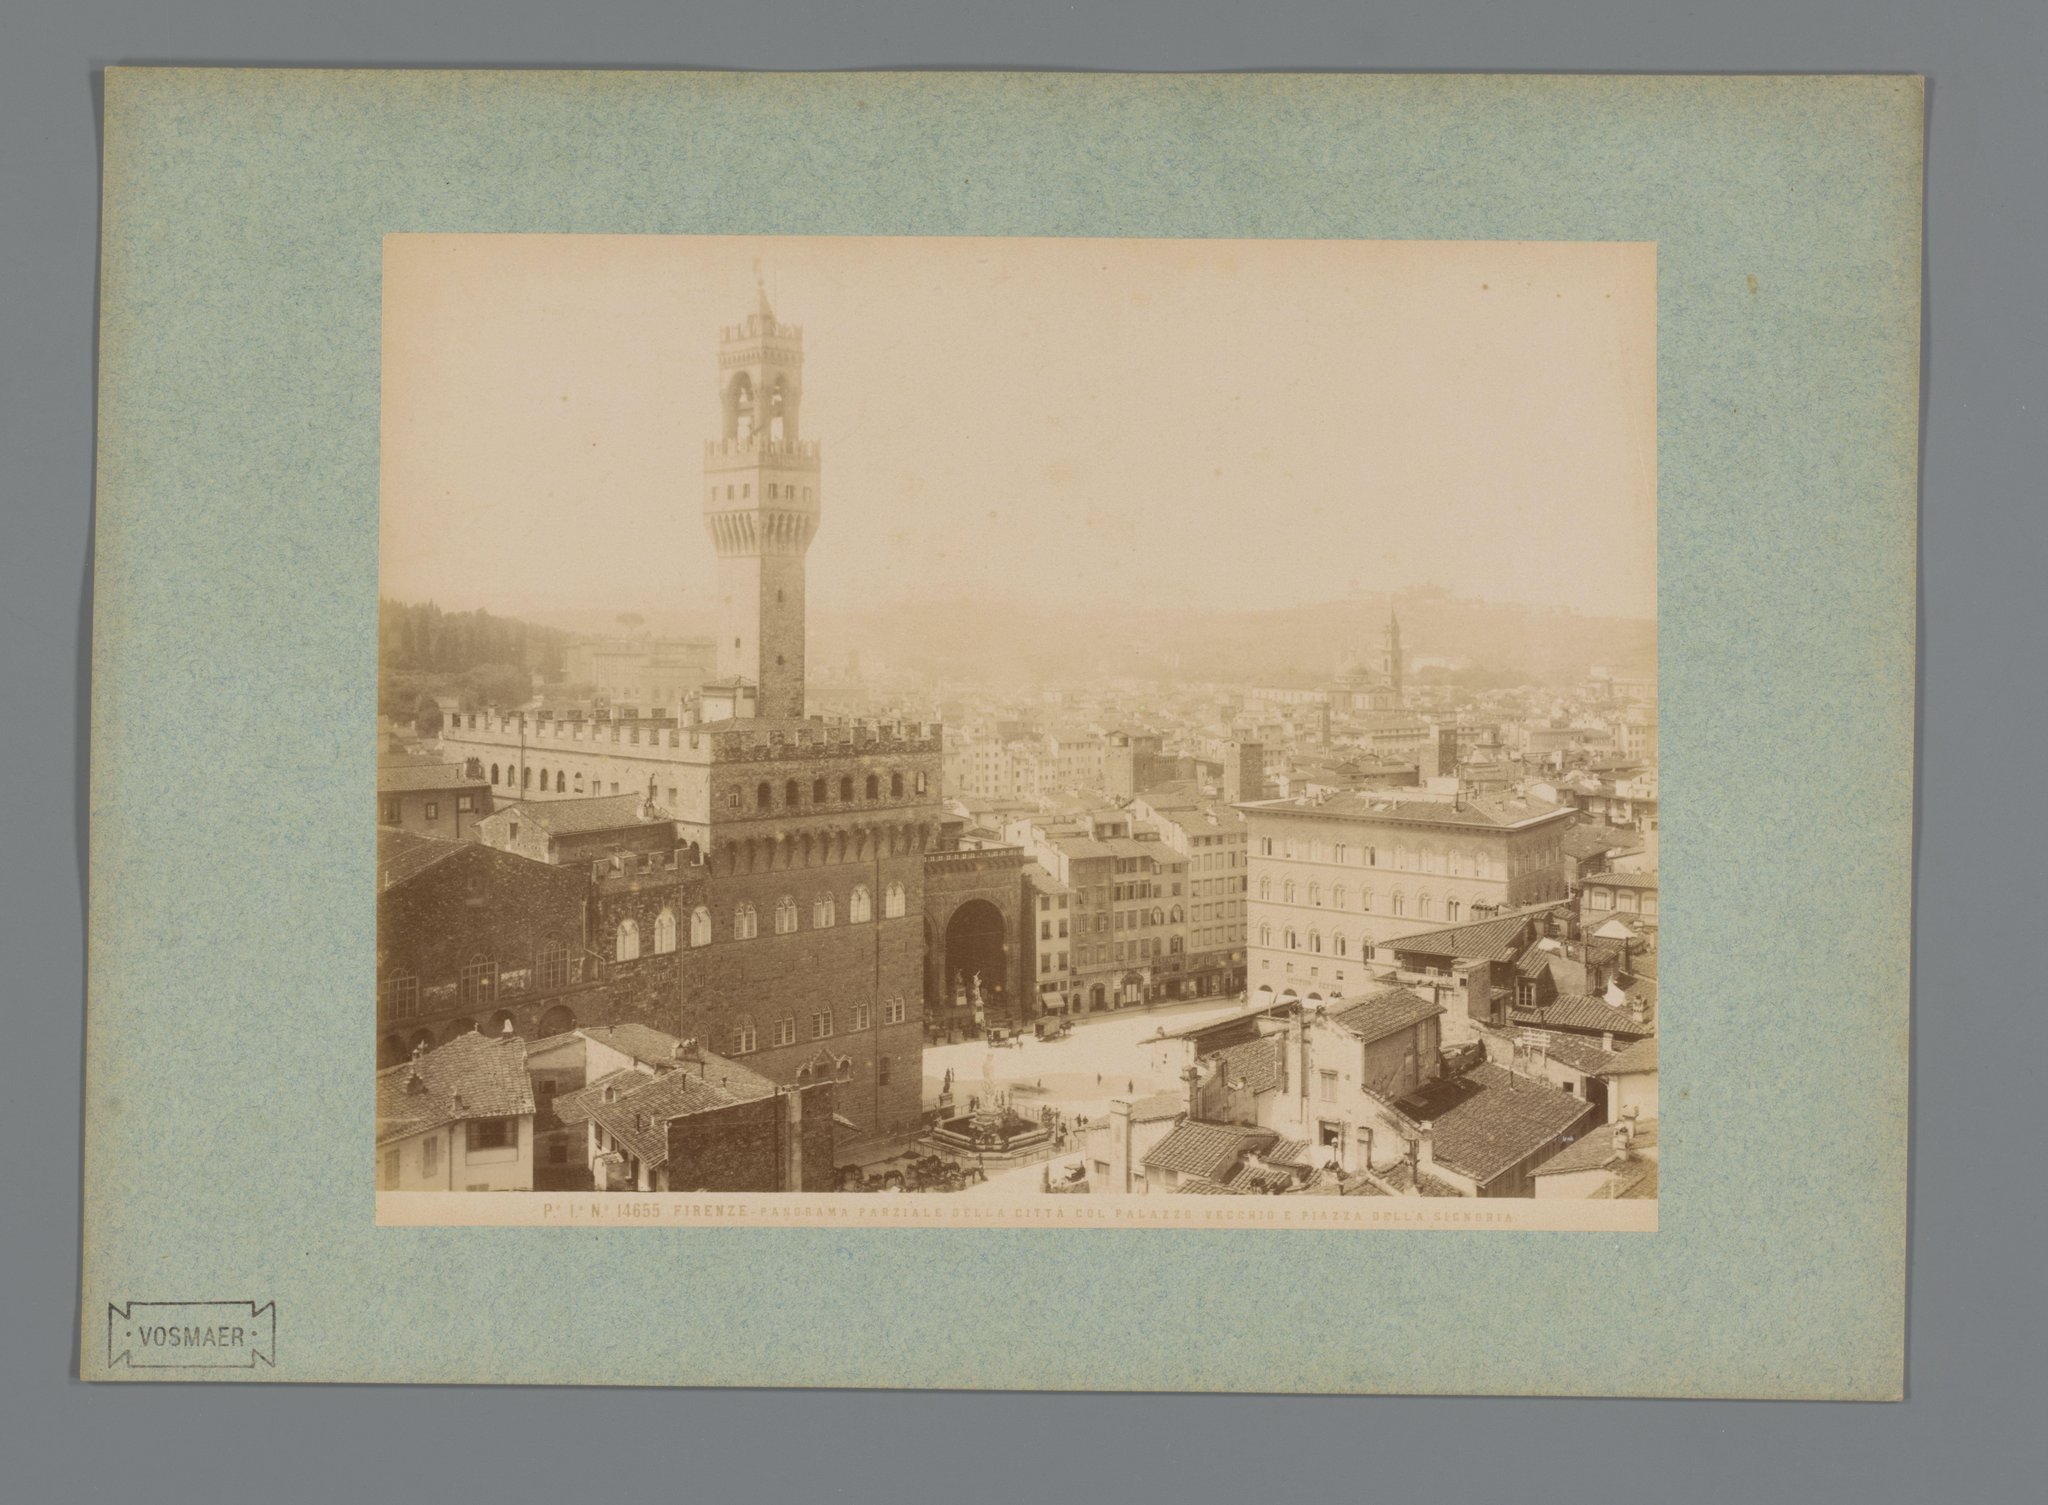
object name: photograph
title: Gezicht op het Piazza della Signoria en het Palazzo Vecchio te Florence, Italië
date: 1870-1890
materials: cardboard, paper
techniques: albumen print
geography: florence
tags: square, place, circus, etc., city-view in general; 'veduta'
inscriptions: collector's mark: ‘VOSMAER’, number: ‘Pe. 1a. No. 14655’